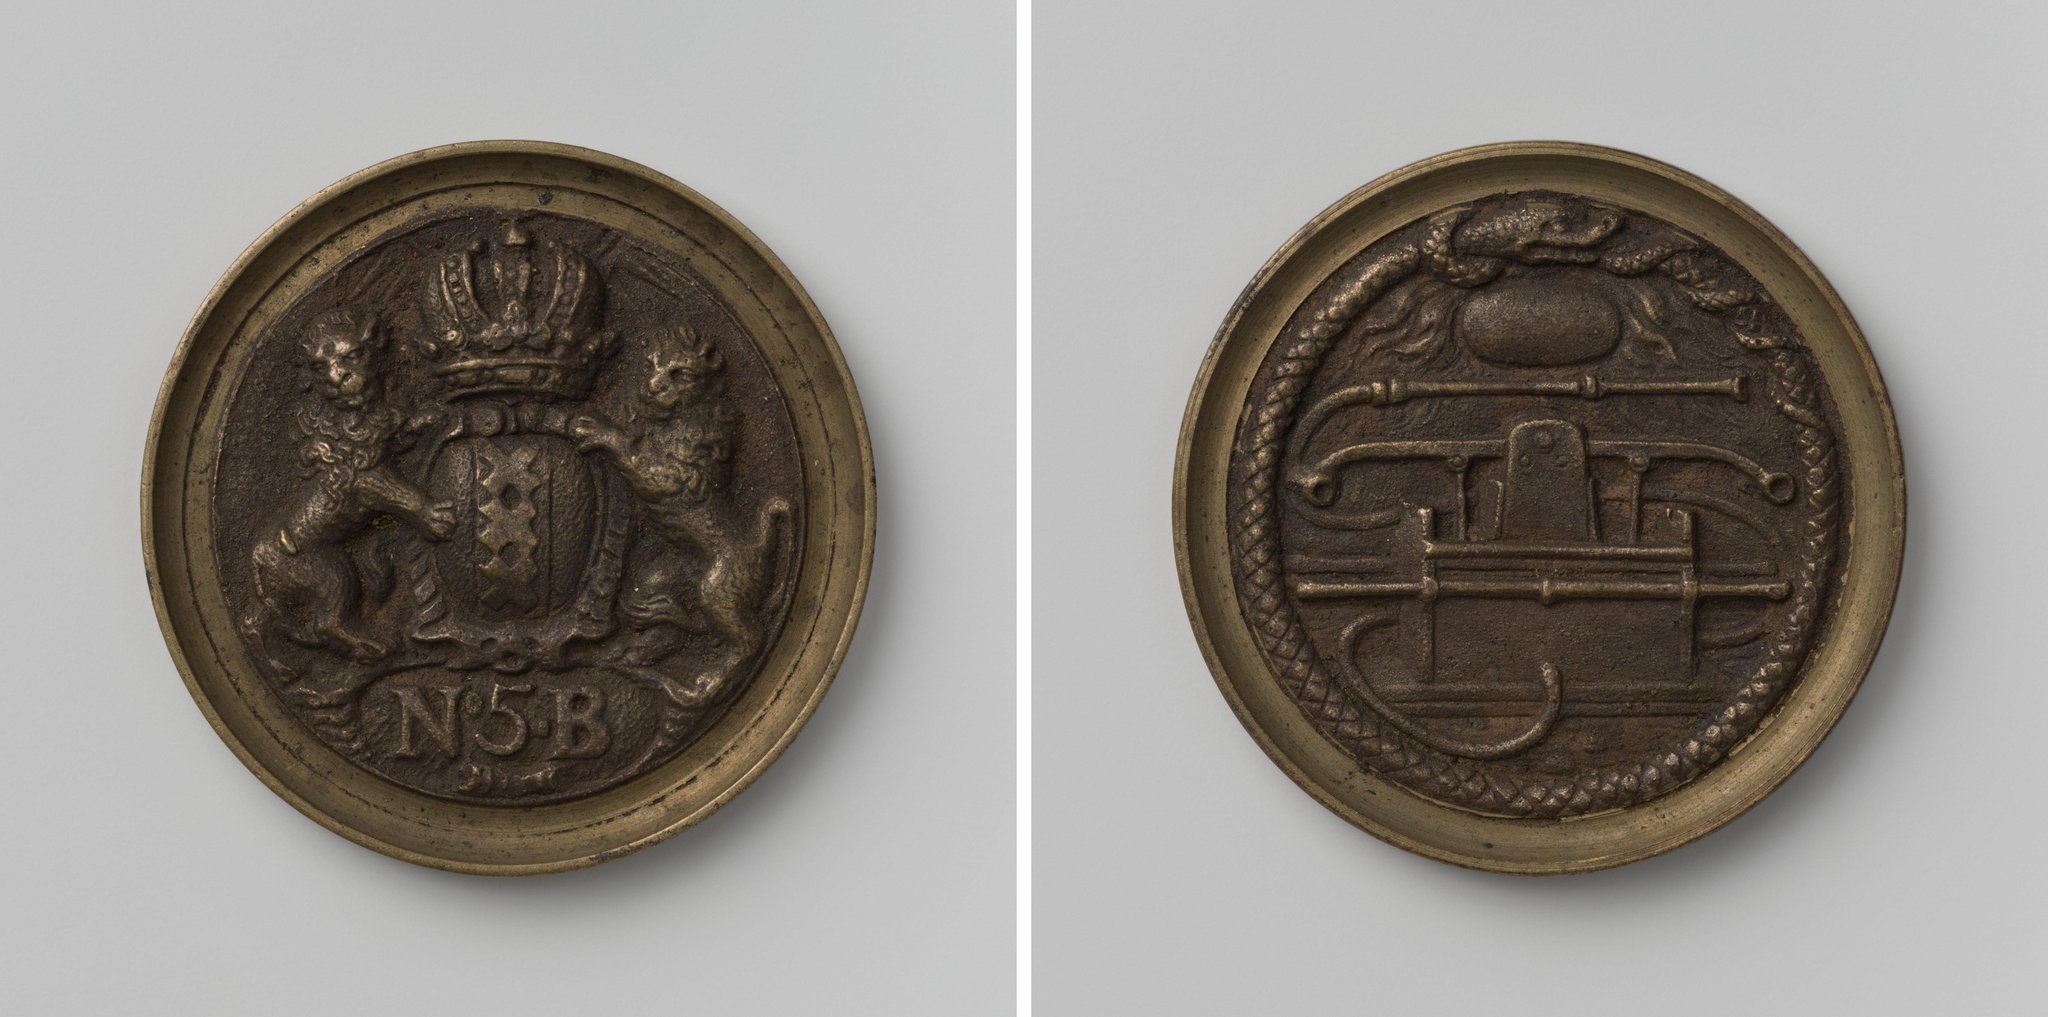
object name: fire engine medal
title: Amsterdam, brandspuitpenning van wijk 5 Buitenwijk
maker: Anonymous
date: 1680-1800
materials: brass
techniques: casting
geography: amsterdam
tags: amsterdam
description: Messing penning. Voorzijde: gekroond wapenschild, geflankeerd door twee leeuwen boven cartouche met opschrift No. 5.B. Keerzijde: brandspuit onder leeg cartouche binnen slangerond